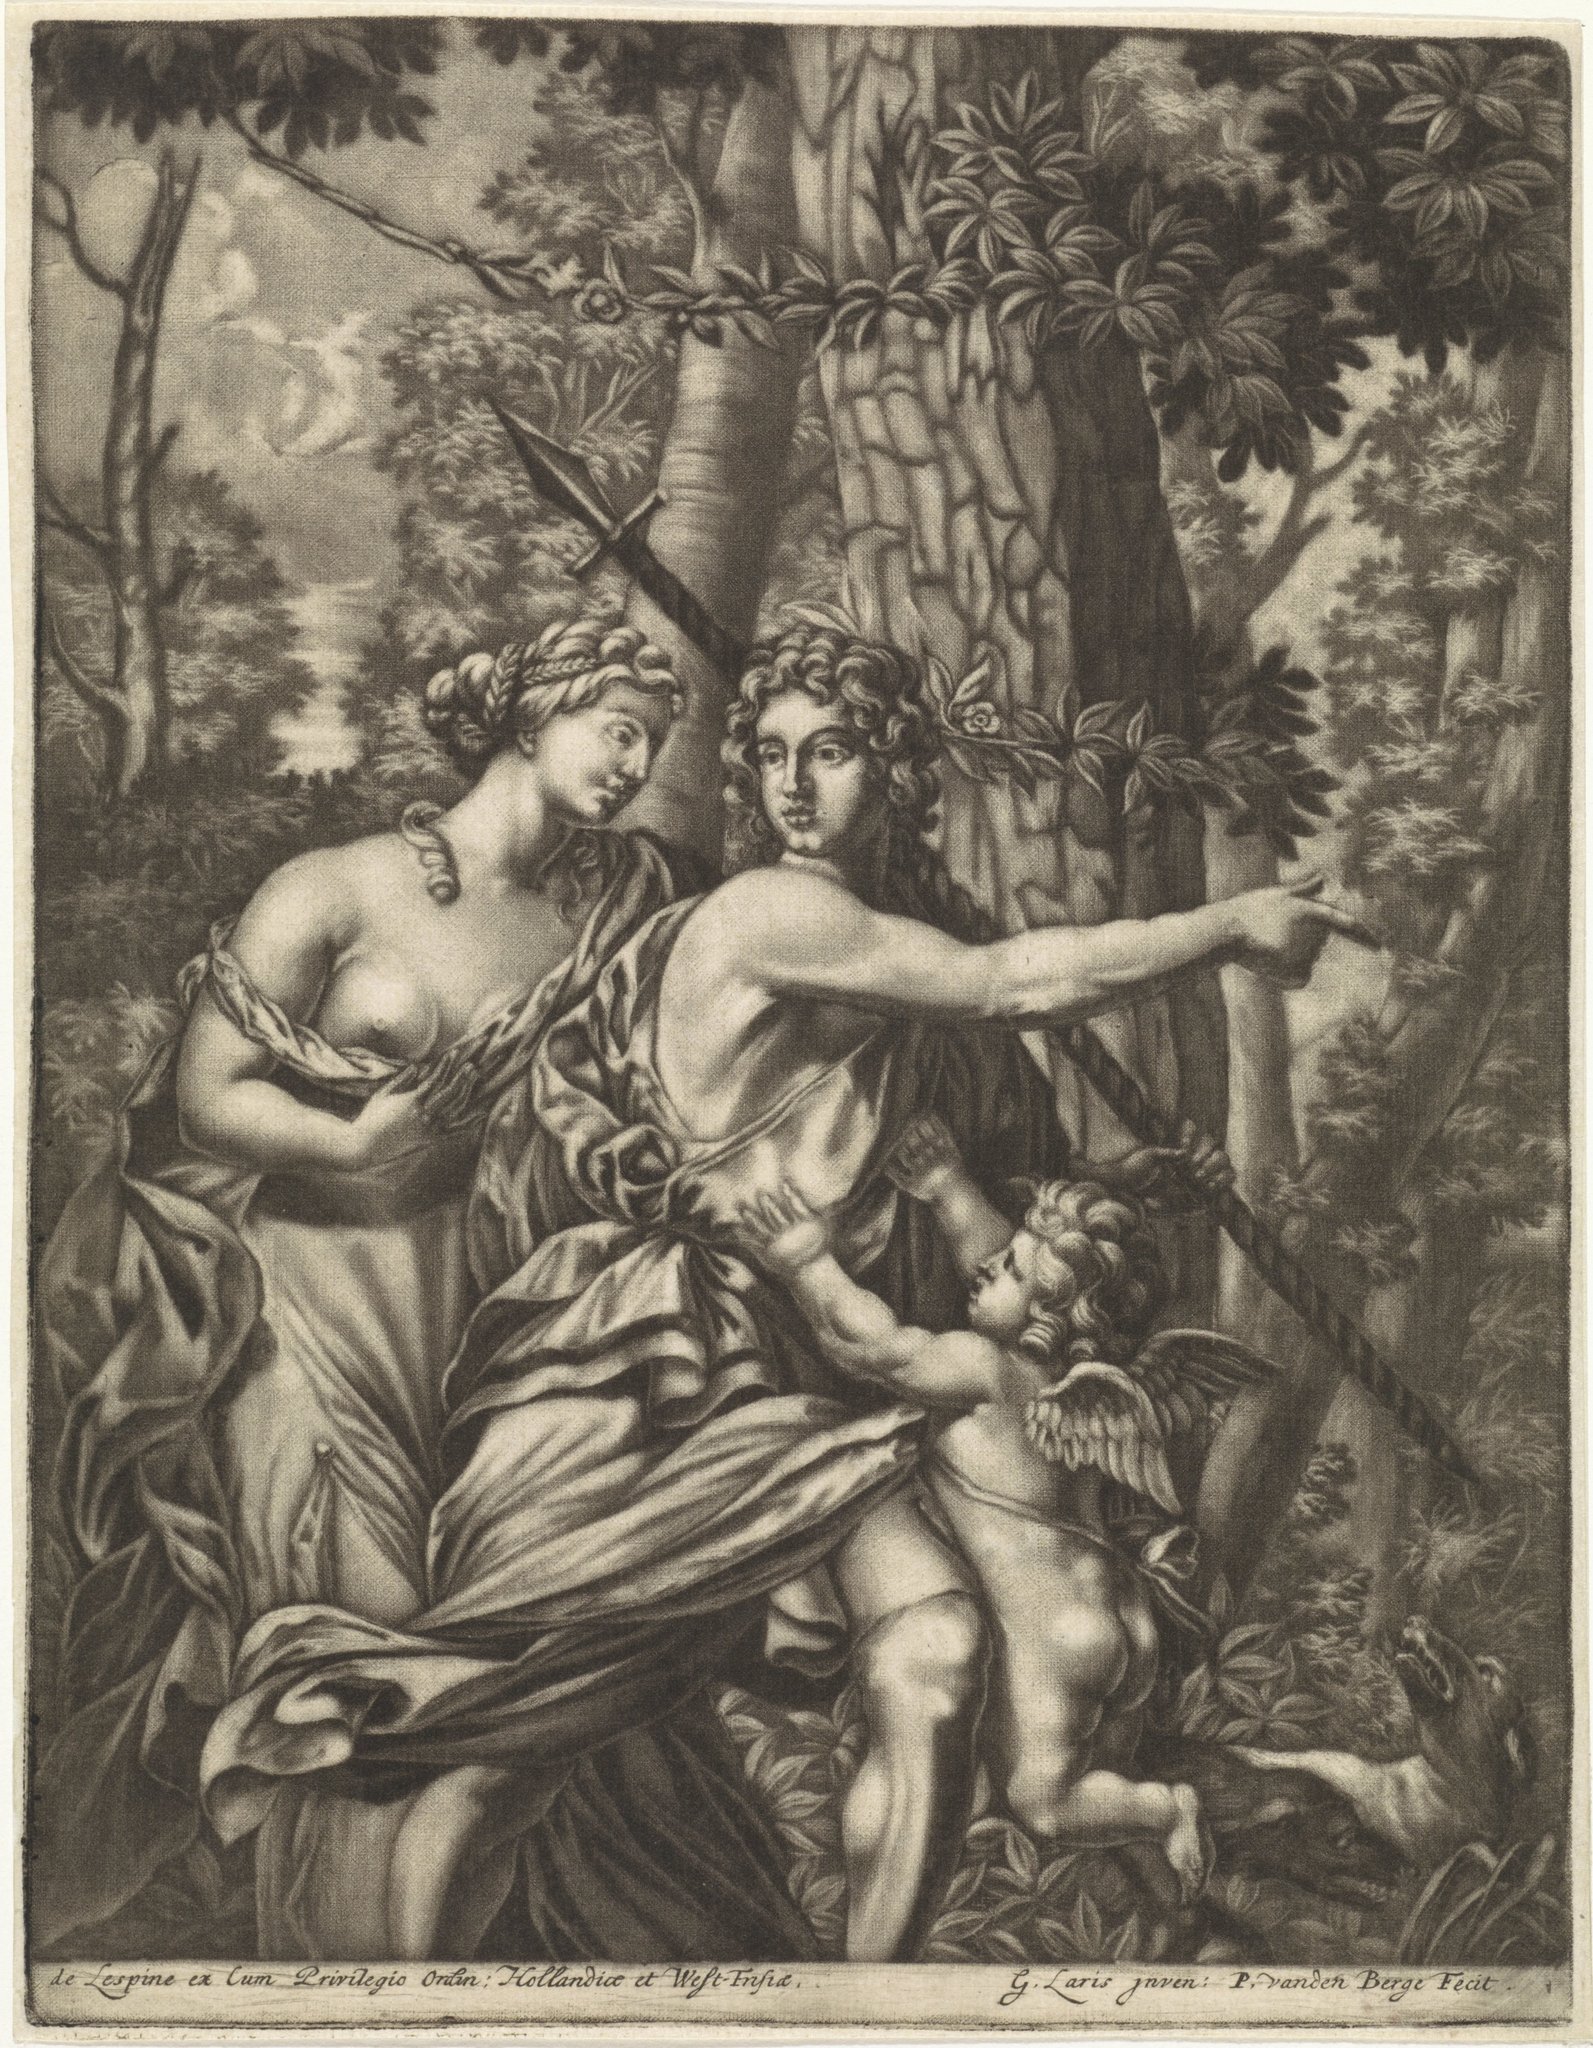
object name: print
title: Venus weerhoudt Adonis van de jacht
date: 1692-1737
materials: paper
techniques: engraving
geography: amsterdam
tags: venus and adonis as lovers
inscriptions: collector's mark: Lugt 240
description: Venus en Amor proberen Adonis te beletten om op jacht te gaan. Adonis gaat echter toch jagen; hij draagt een lans en naast hem lopen twee jachthonden.